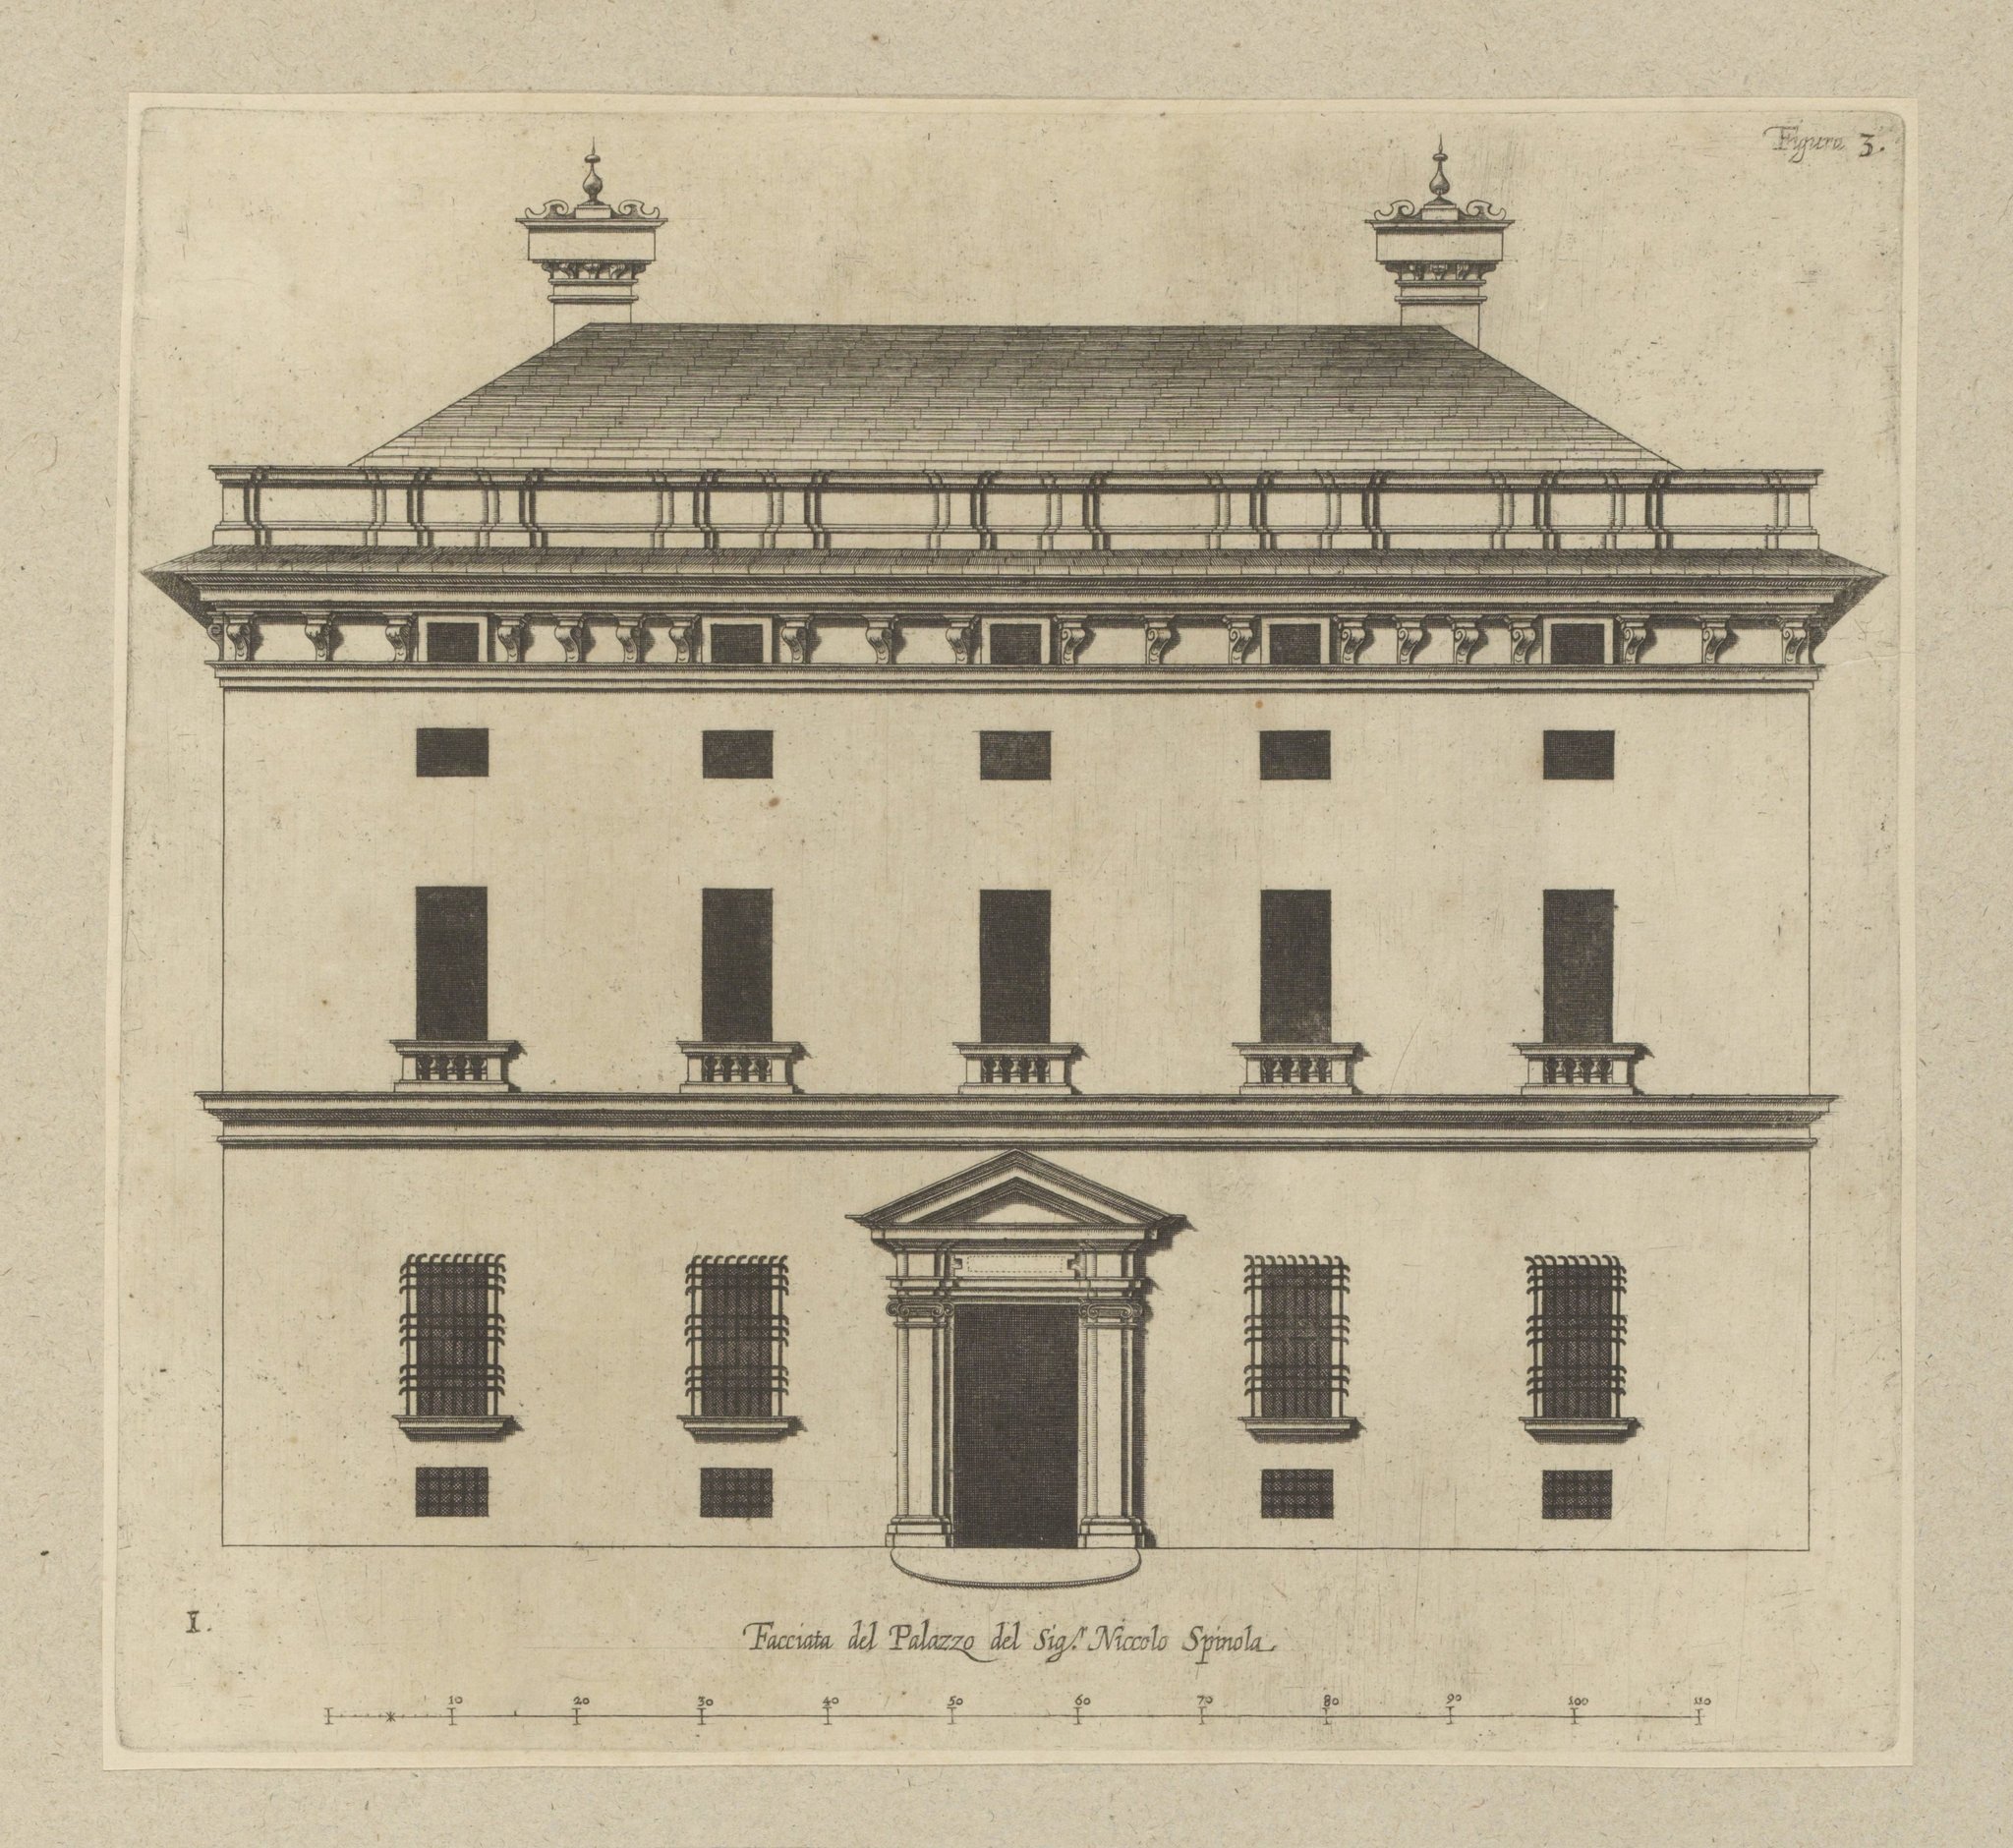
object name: album leaf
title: Opstand van de façade van het Palazzo Doria te Genua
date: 1622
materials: paper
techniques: engraving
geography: antwerp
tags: hôtel, i.e. small palace in city, façade (of house or building), exterior ~ architectural design or model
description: Deze prent maakt deel uit van een album.